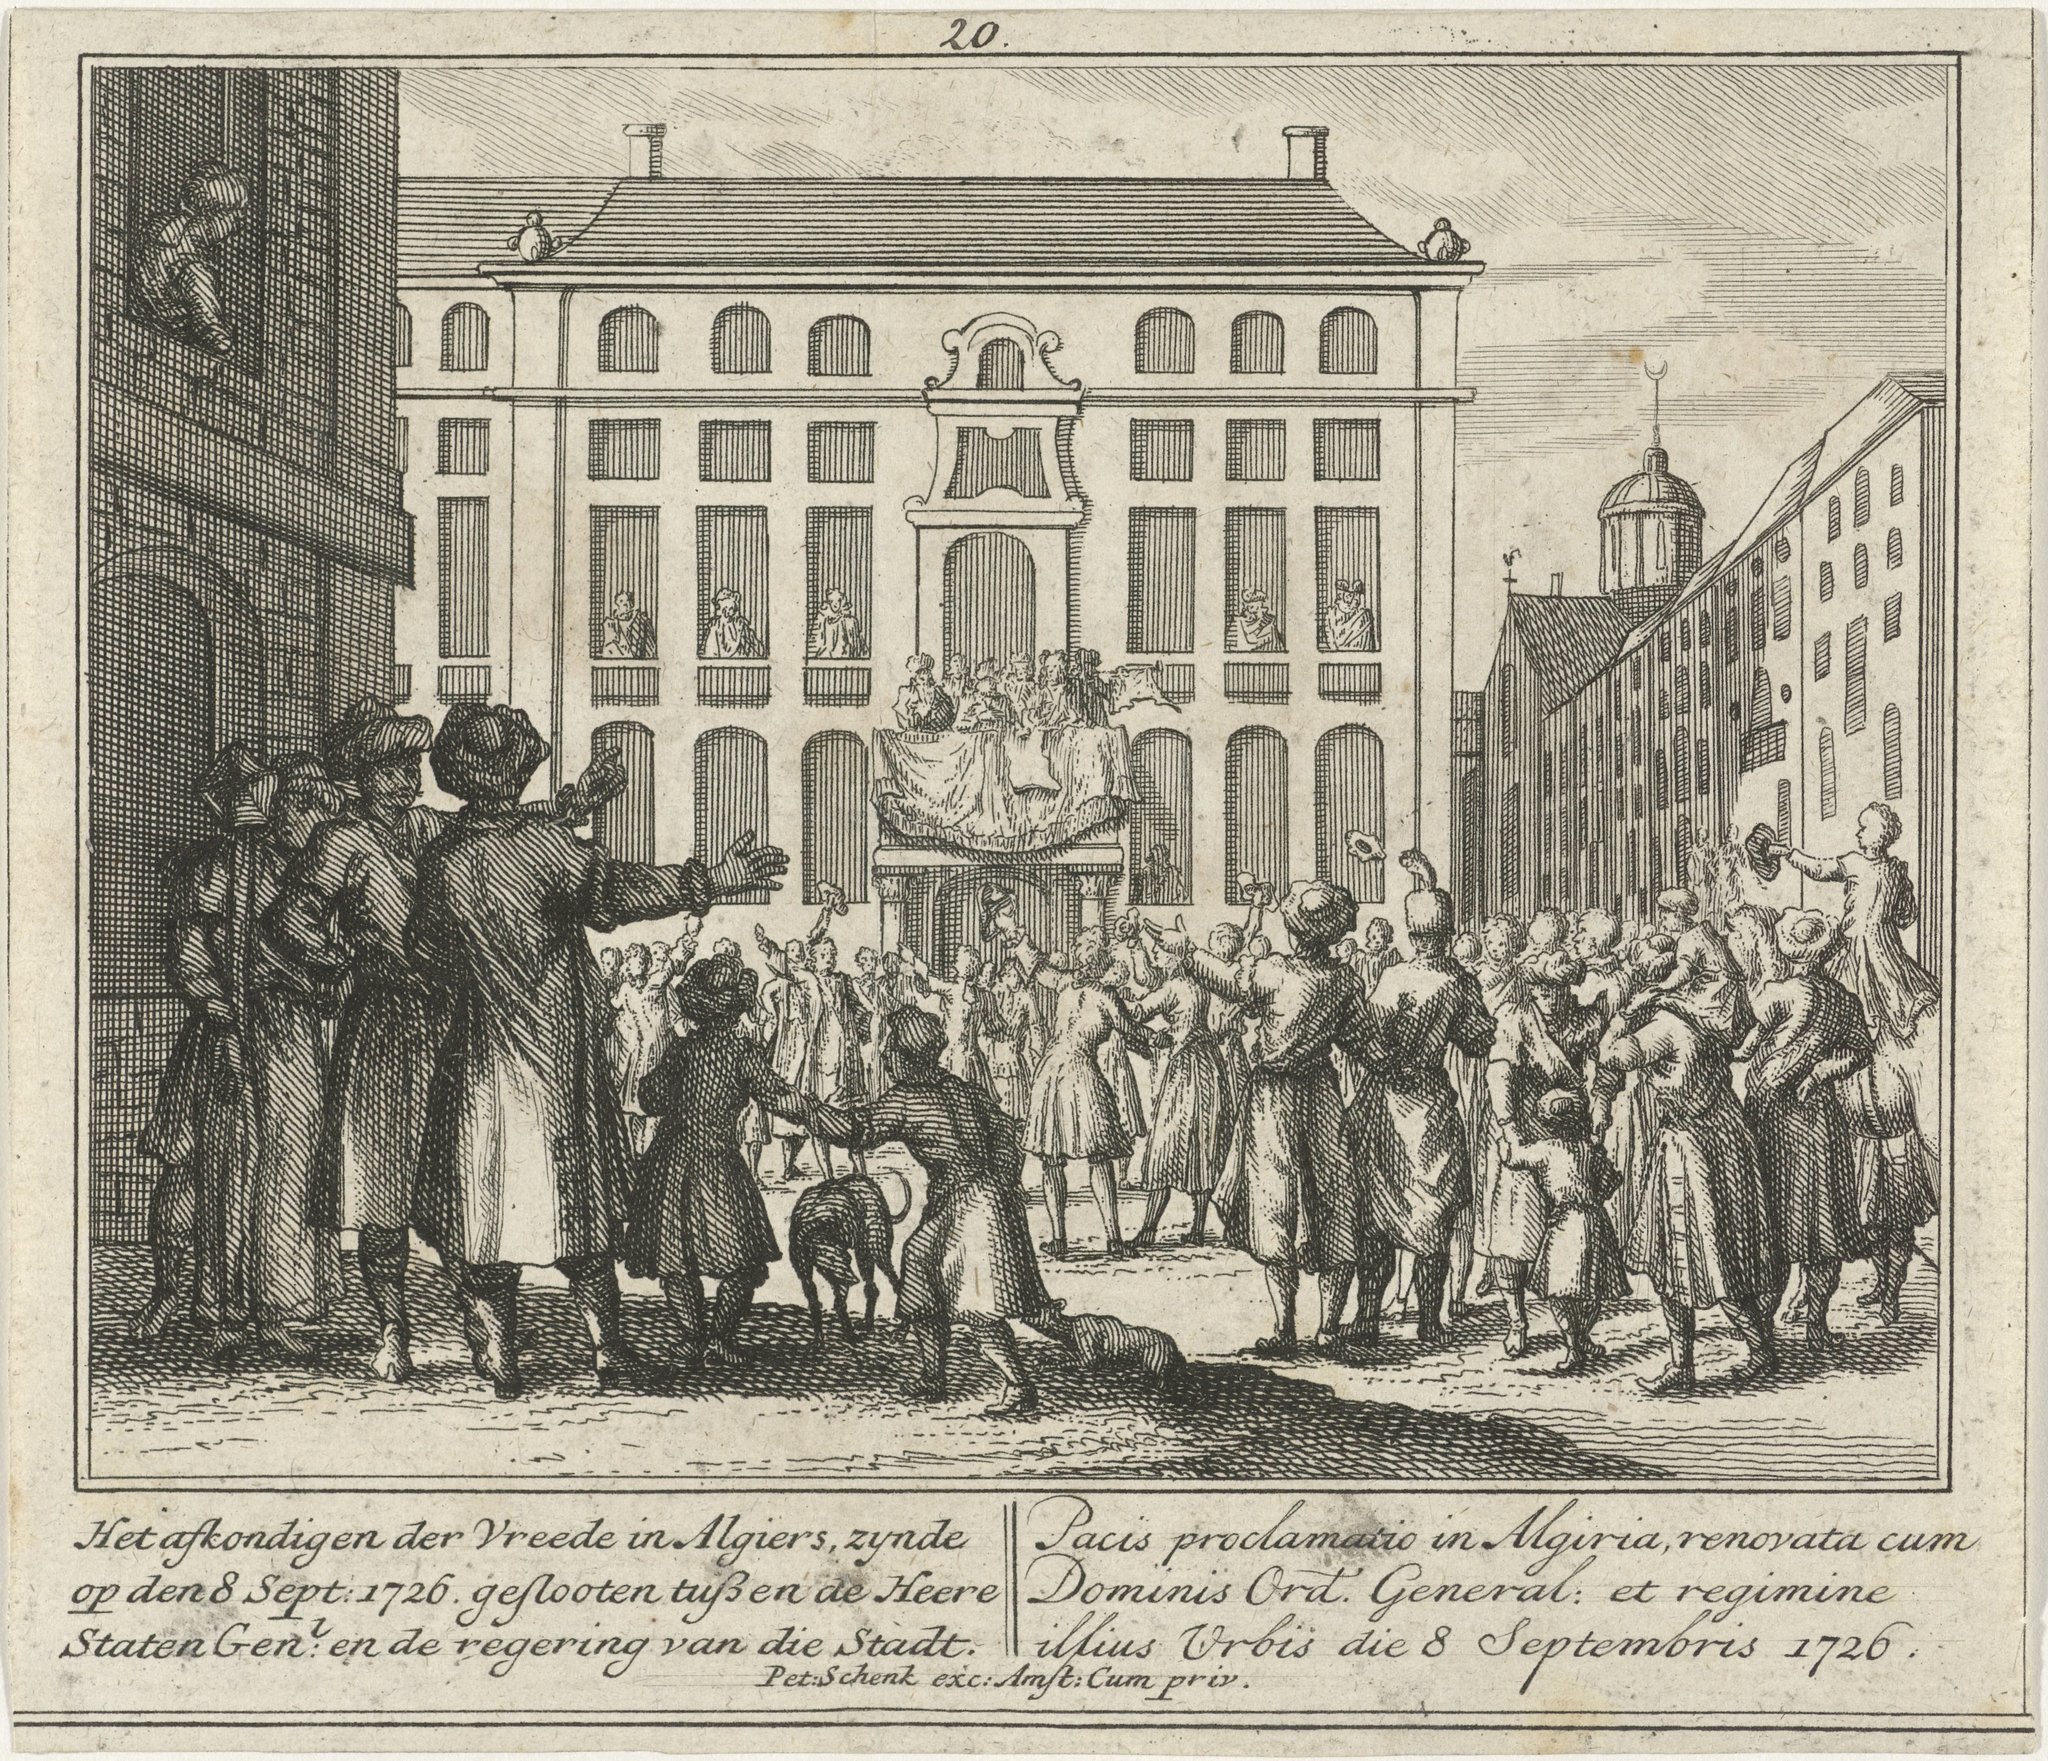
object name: print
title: Het afkondigen van de vrede gesloten tussen de Staten-Generaal en het bestuur van Algiers, 1726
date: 1726-1728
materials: paper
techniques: etching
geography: amsterdam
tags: proclamation of peace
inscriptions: collector's mark: Lugt 2228, number: ‘20’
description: Het afkondigen te Algiers van de vrede, gesloten tussen de Staten-Generaal en het bestuur van Algiers, 8 september 1726. Met onderschriften in het Nederlands en Frans. Fragment van een grote plaat met negen voorstellingen van gebeurtenissen uit het jaar 1726.